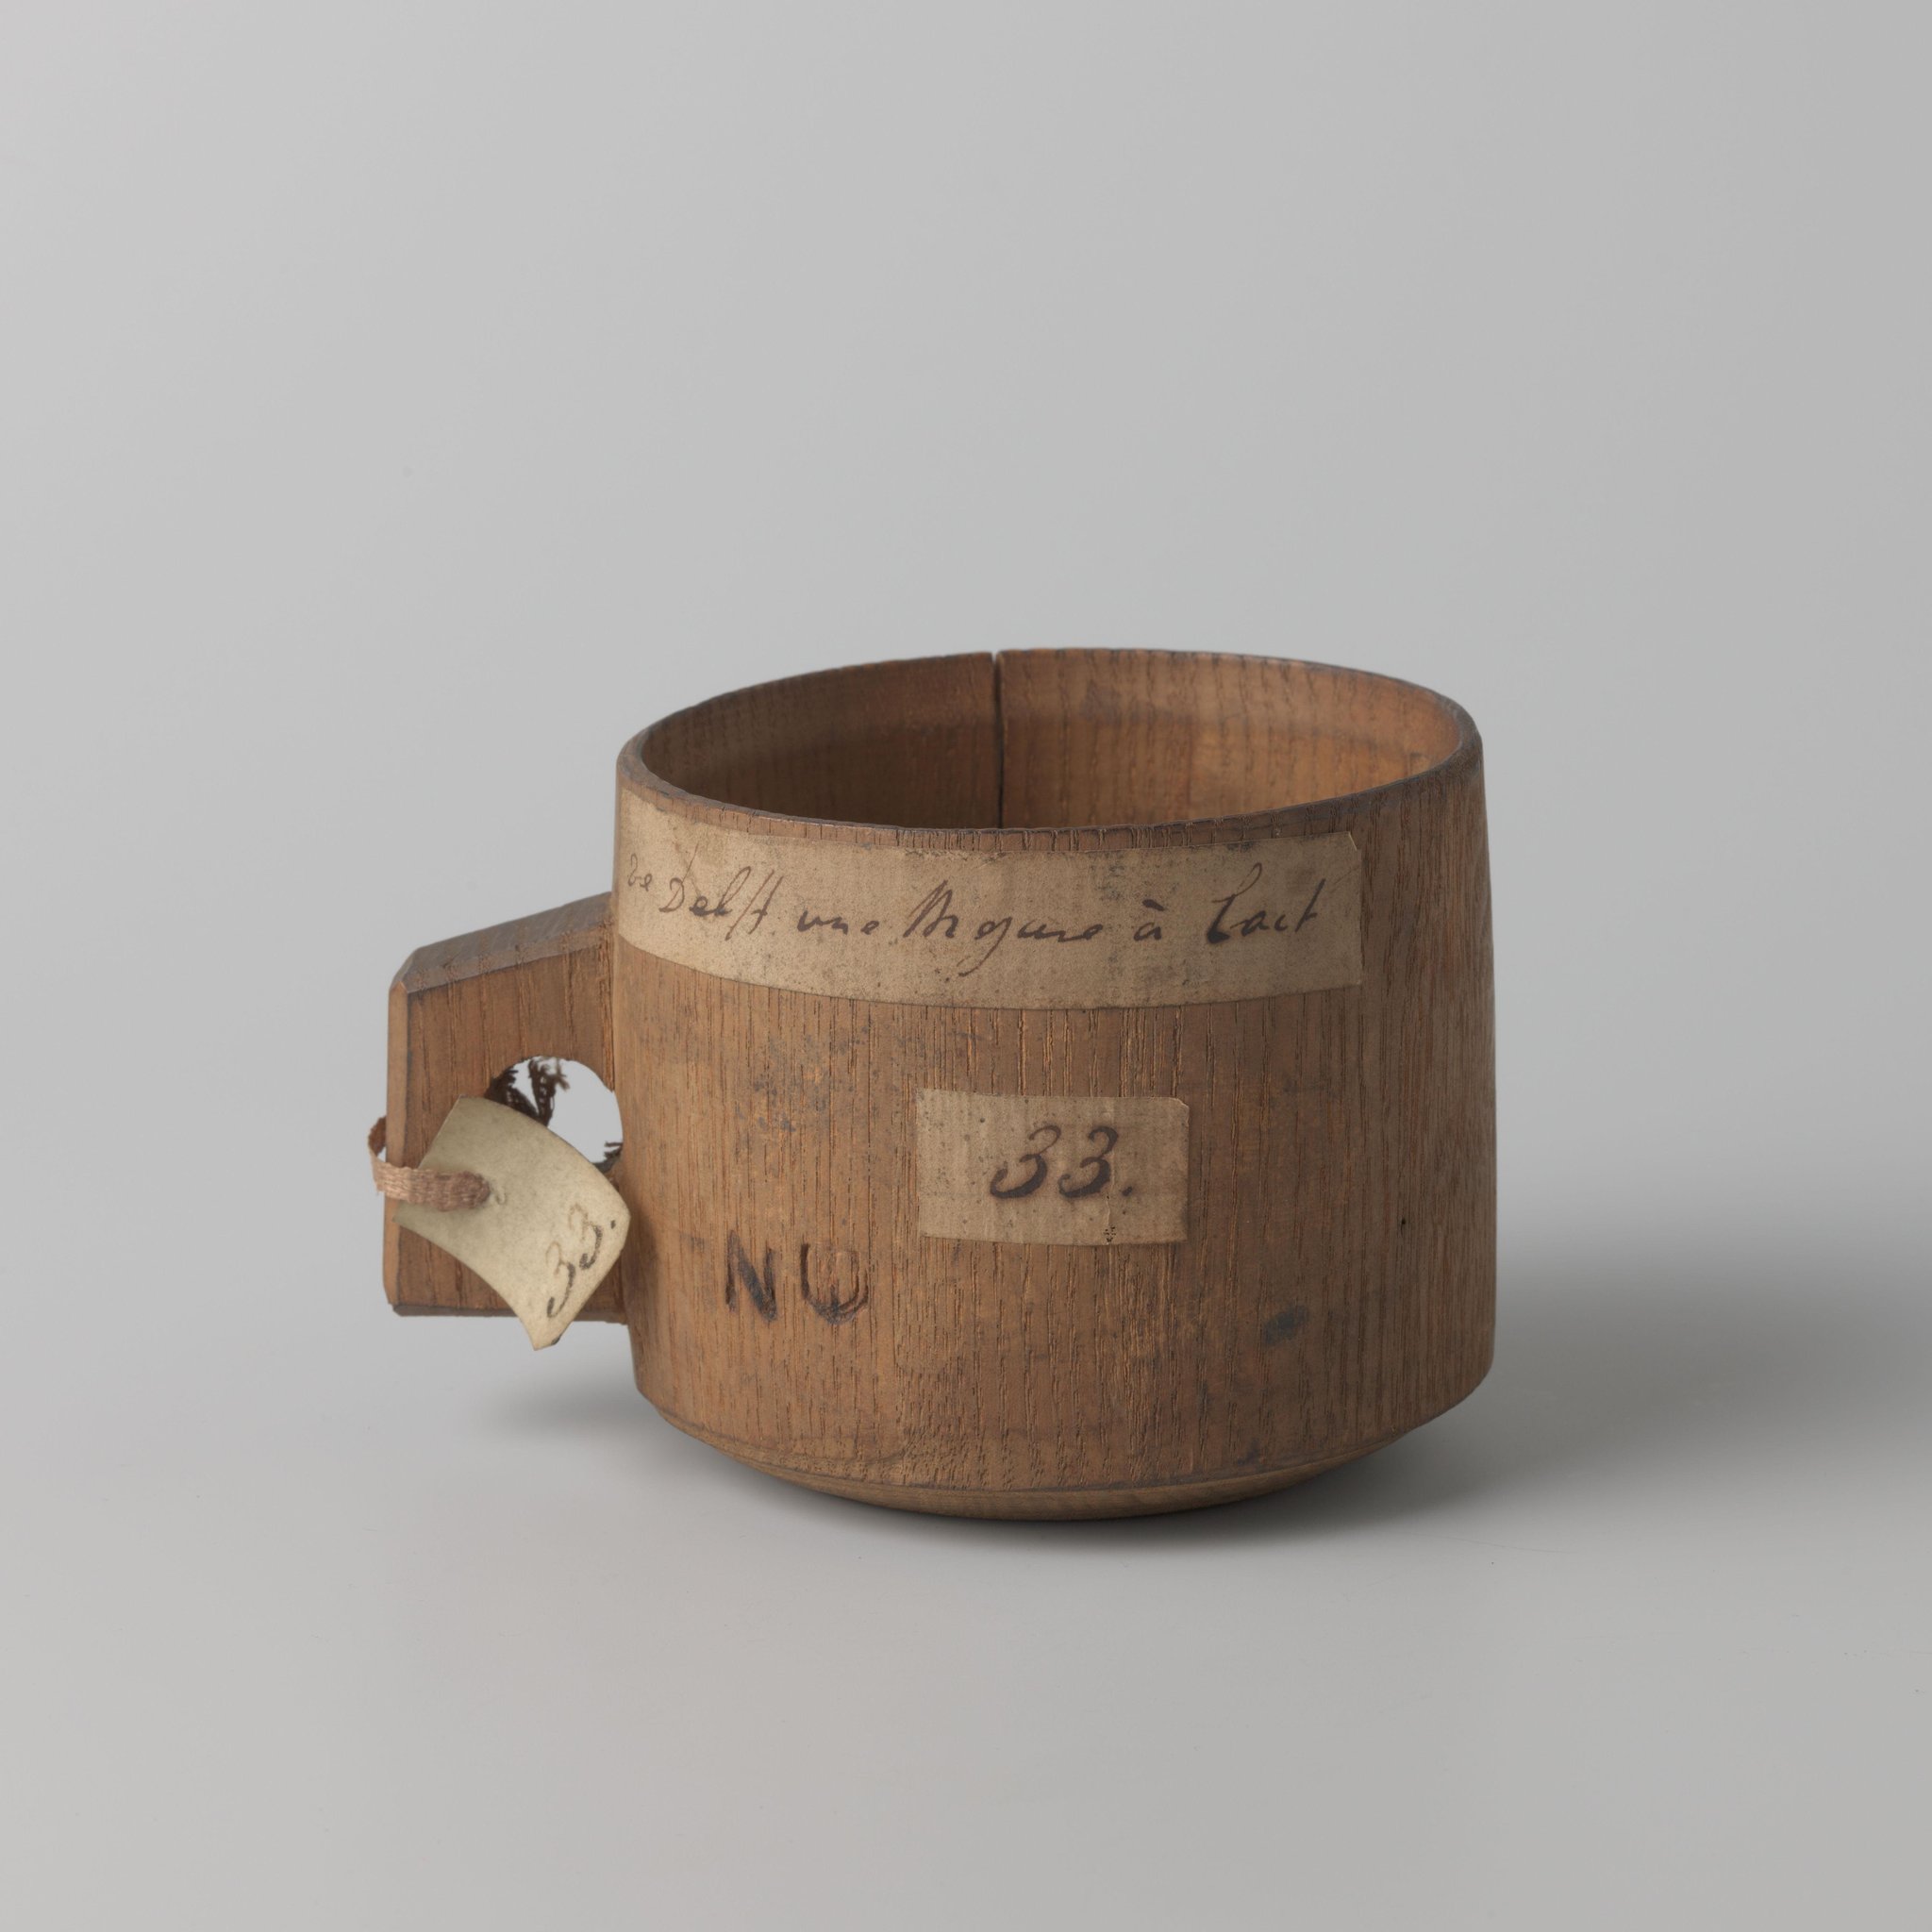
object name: melkmaat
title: Een melk kop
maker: Anonymous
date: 1800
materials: wood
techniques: turning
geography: delft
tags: delft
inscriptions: title: ‘de Delft une Mesure à lait / nr 33’, inscription: ‘33’, title: ‘Delft / Een Melk kop’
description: Inhoudsmaat met oor. Gemerkt, getiteld, 2 etiketten en v.z.v. label aan lintje.